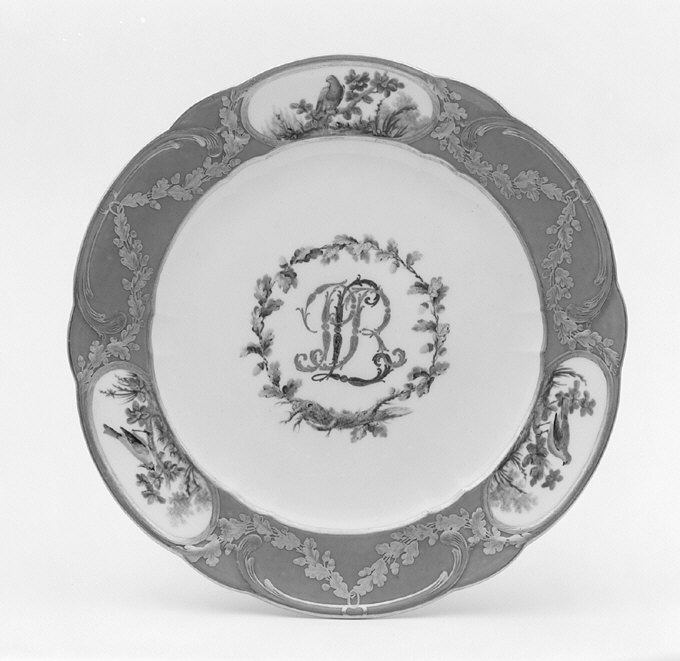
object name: plate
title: Plate (assiette à palmes) (one of four) (part of a service)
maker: sèvres manufactory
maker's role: manufactory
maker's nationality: french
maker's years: 1740-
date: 1771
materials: soft paste porcelain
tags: birds,insignia